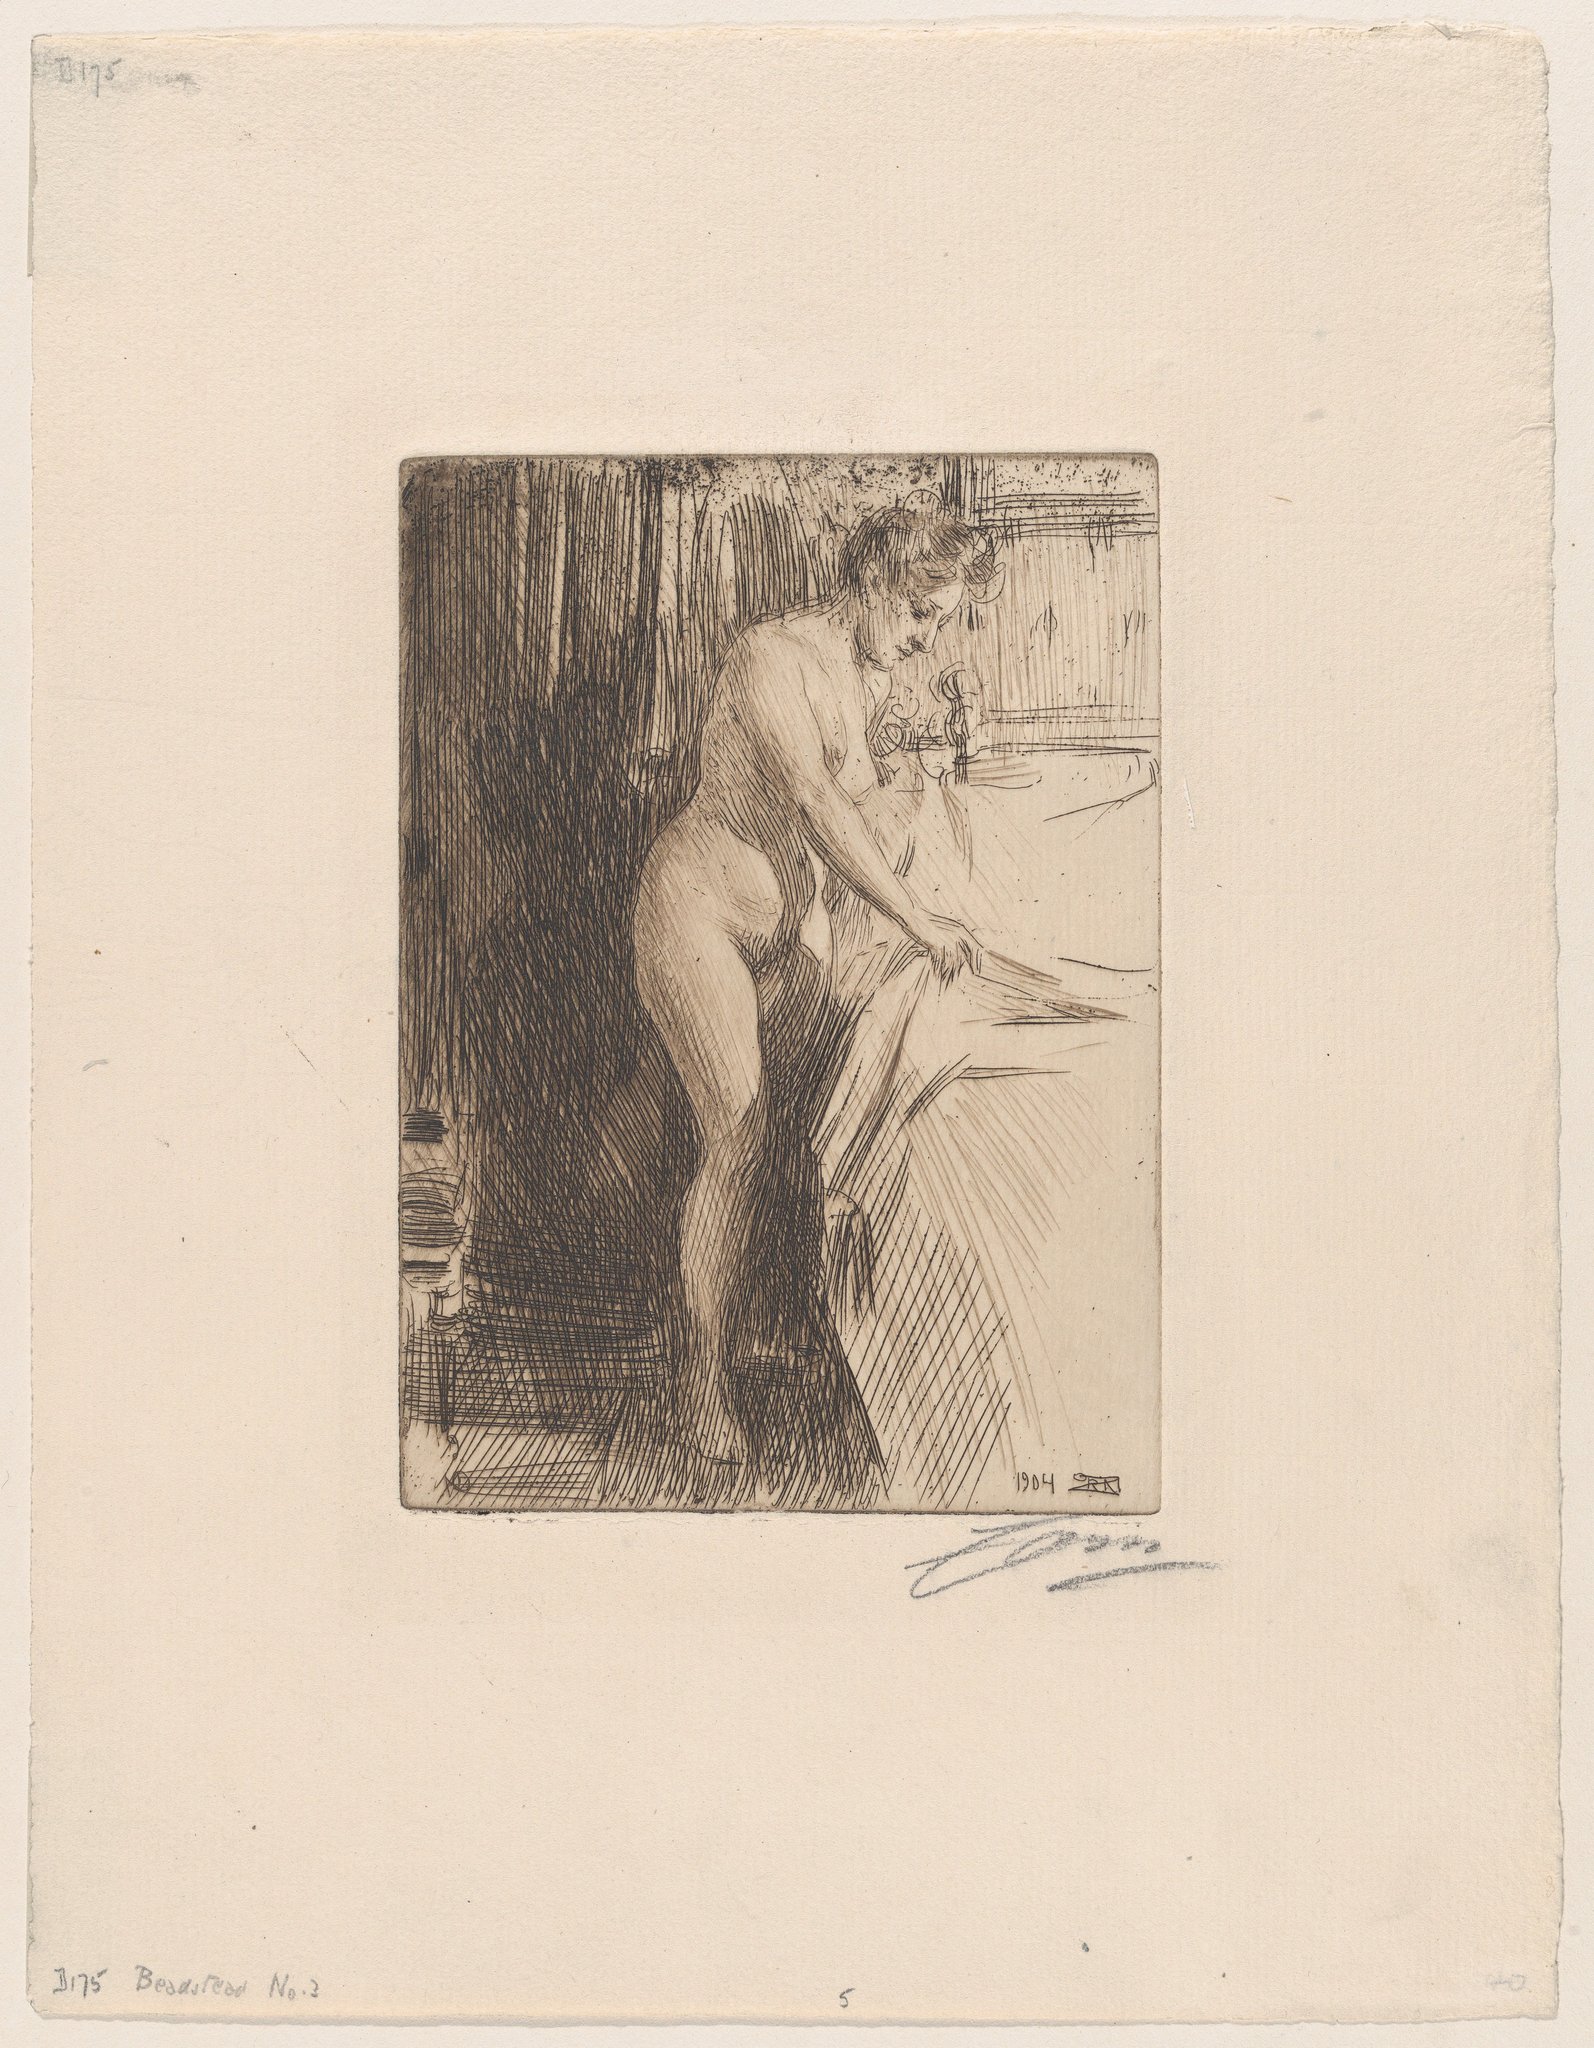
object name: print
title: Olandine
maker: anders zorn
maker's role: artist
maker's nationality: swedish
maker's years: 1860-1920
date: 1904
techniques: etching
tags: female nudes,beds